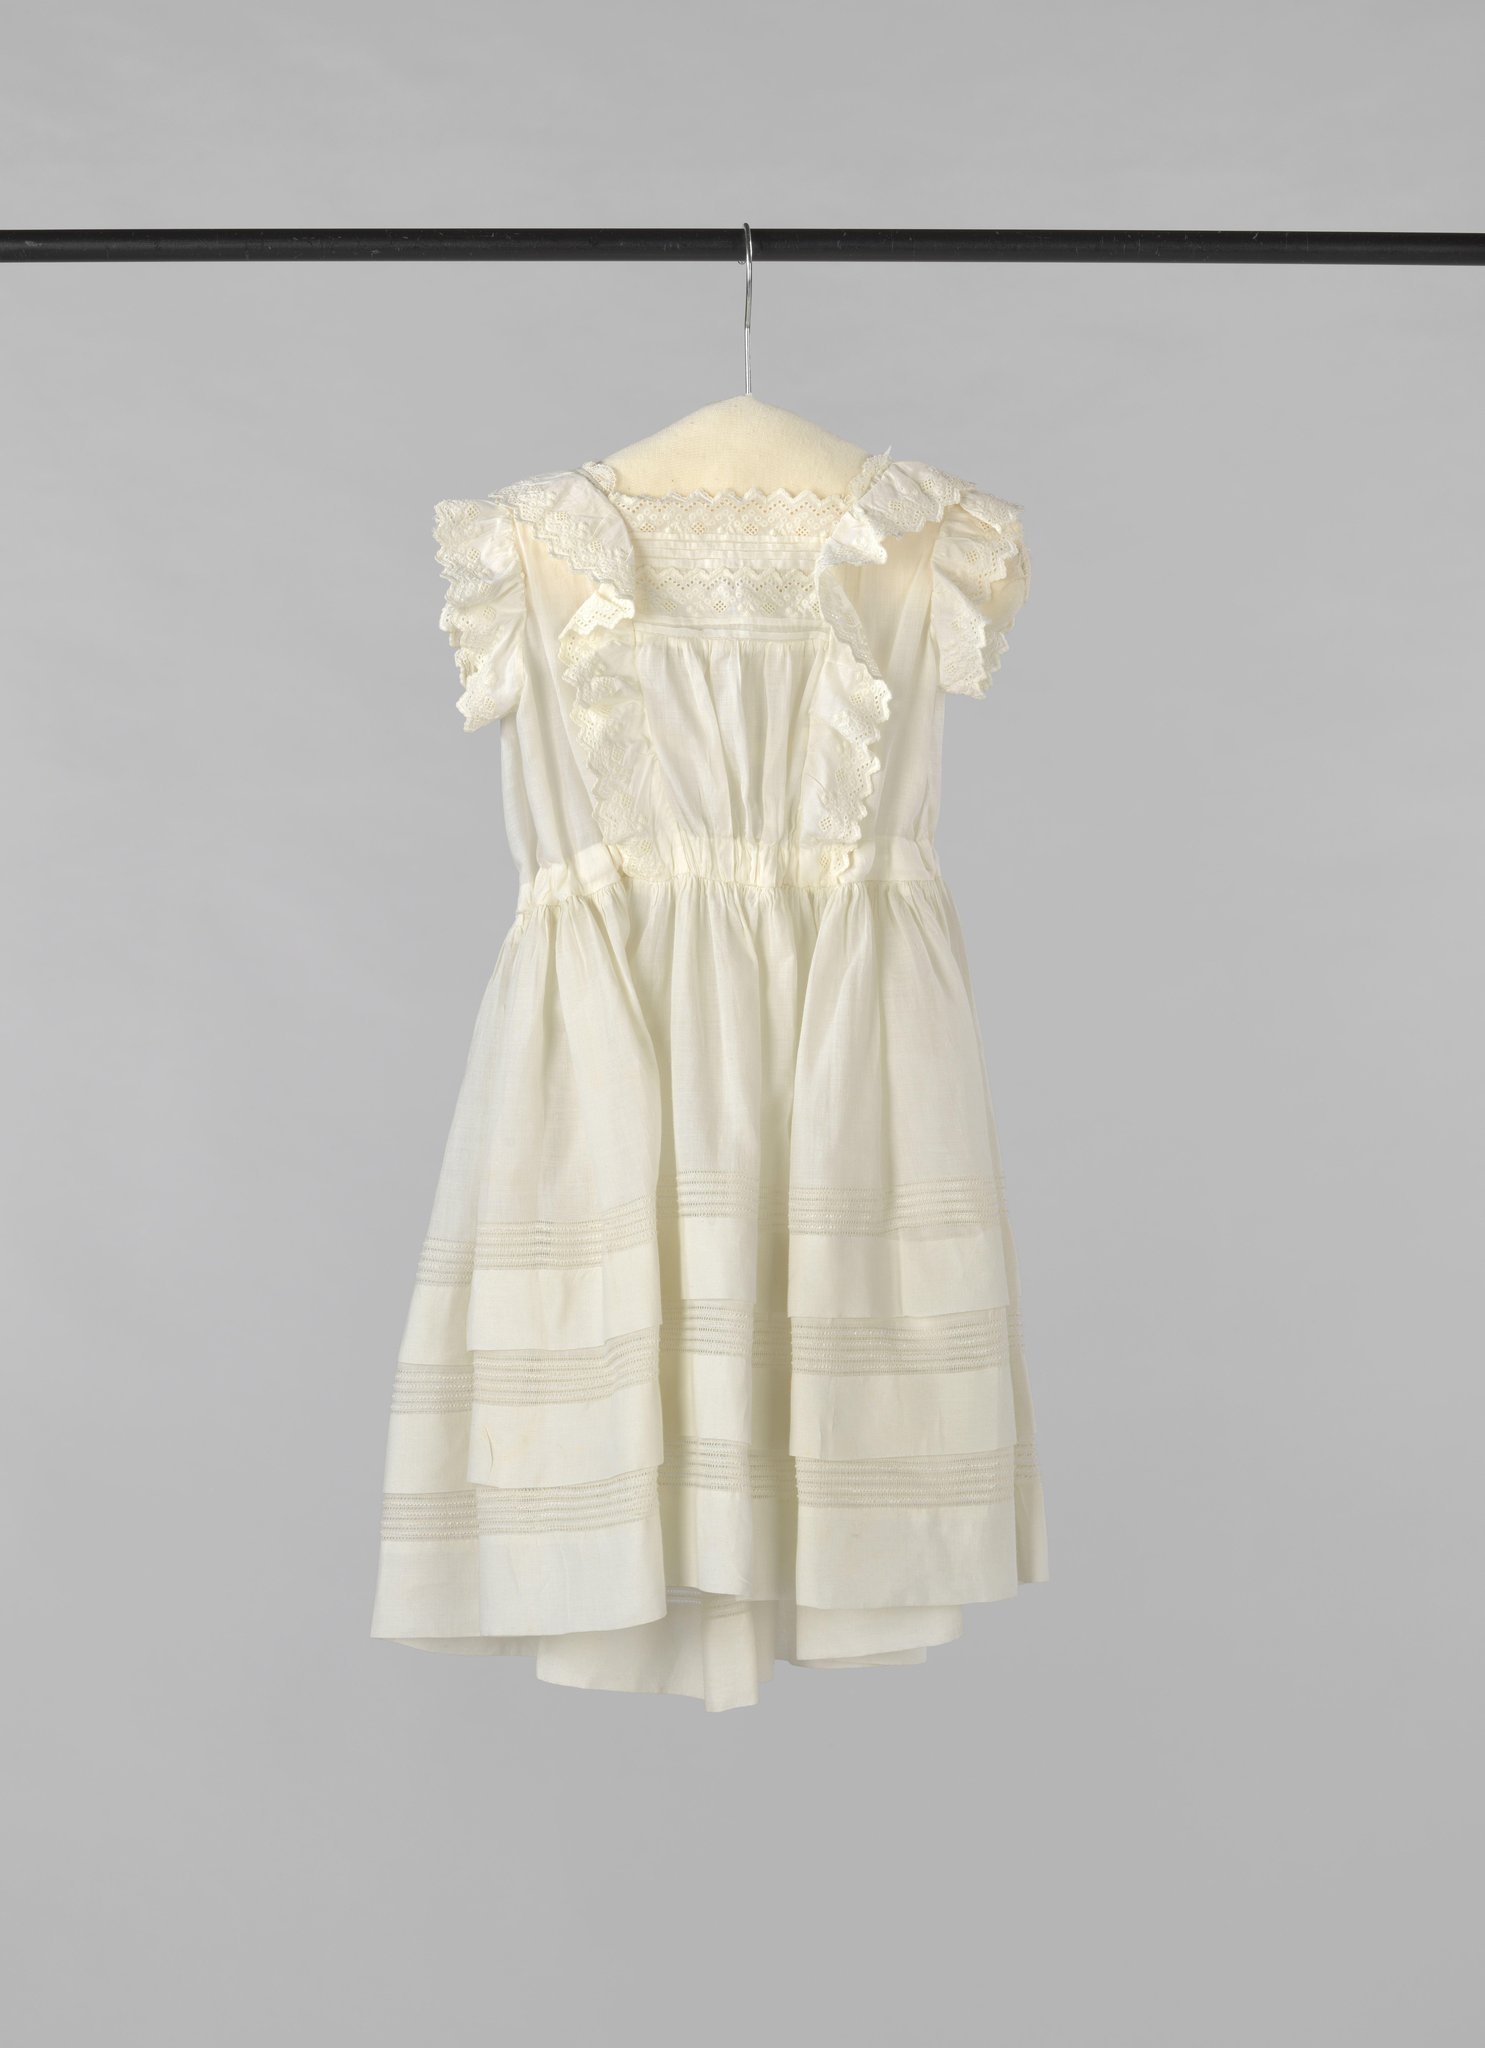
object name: childrenswear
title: Kleuterjurkje van batist met ingeweven ajourranden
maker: Anonymous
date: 1870-1875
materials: textile, mother of pearl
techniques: embroidery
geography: netherlands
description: Kleuterjurkje van batist met ingeweven à-jourranden, versierd met puntstrookjes met engels borduurwerk. Victoriaans: Model: Handgenaaid, lang lijfje, van voren gerimpeld aangezet aan een schouderpas van dubbele, opstaand genomen puntstrookjes. Aangerimpelde vleugels van hetzelfde. Aan de mouwopening eveneens dergelijke strookjes......mouwen. Achtersluiting met parelmoeren knoopjes. Ruim gerimpelde rechte rok, van één stofbaan, waarin onderaan vijfdubbele à-jourranden en brede oprijgen en zoom. Toestand: In 1979 gewassen.